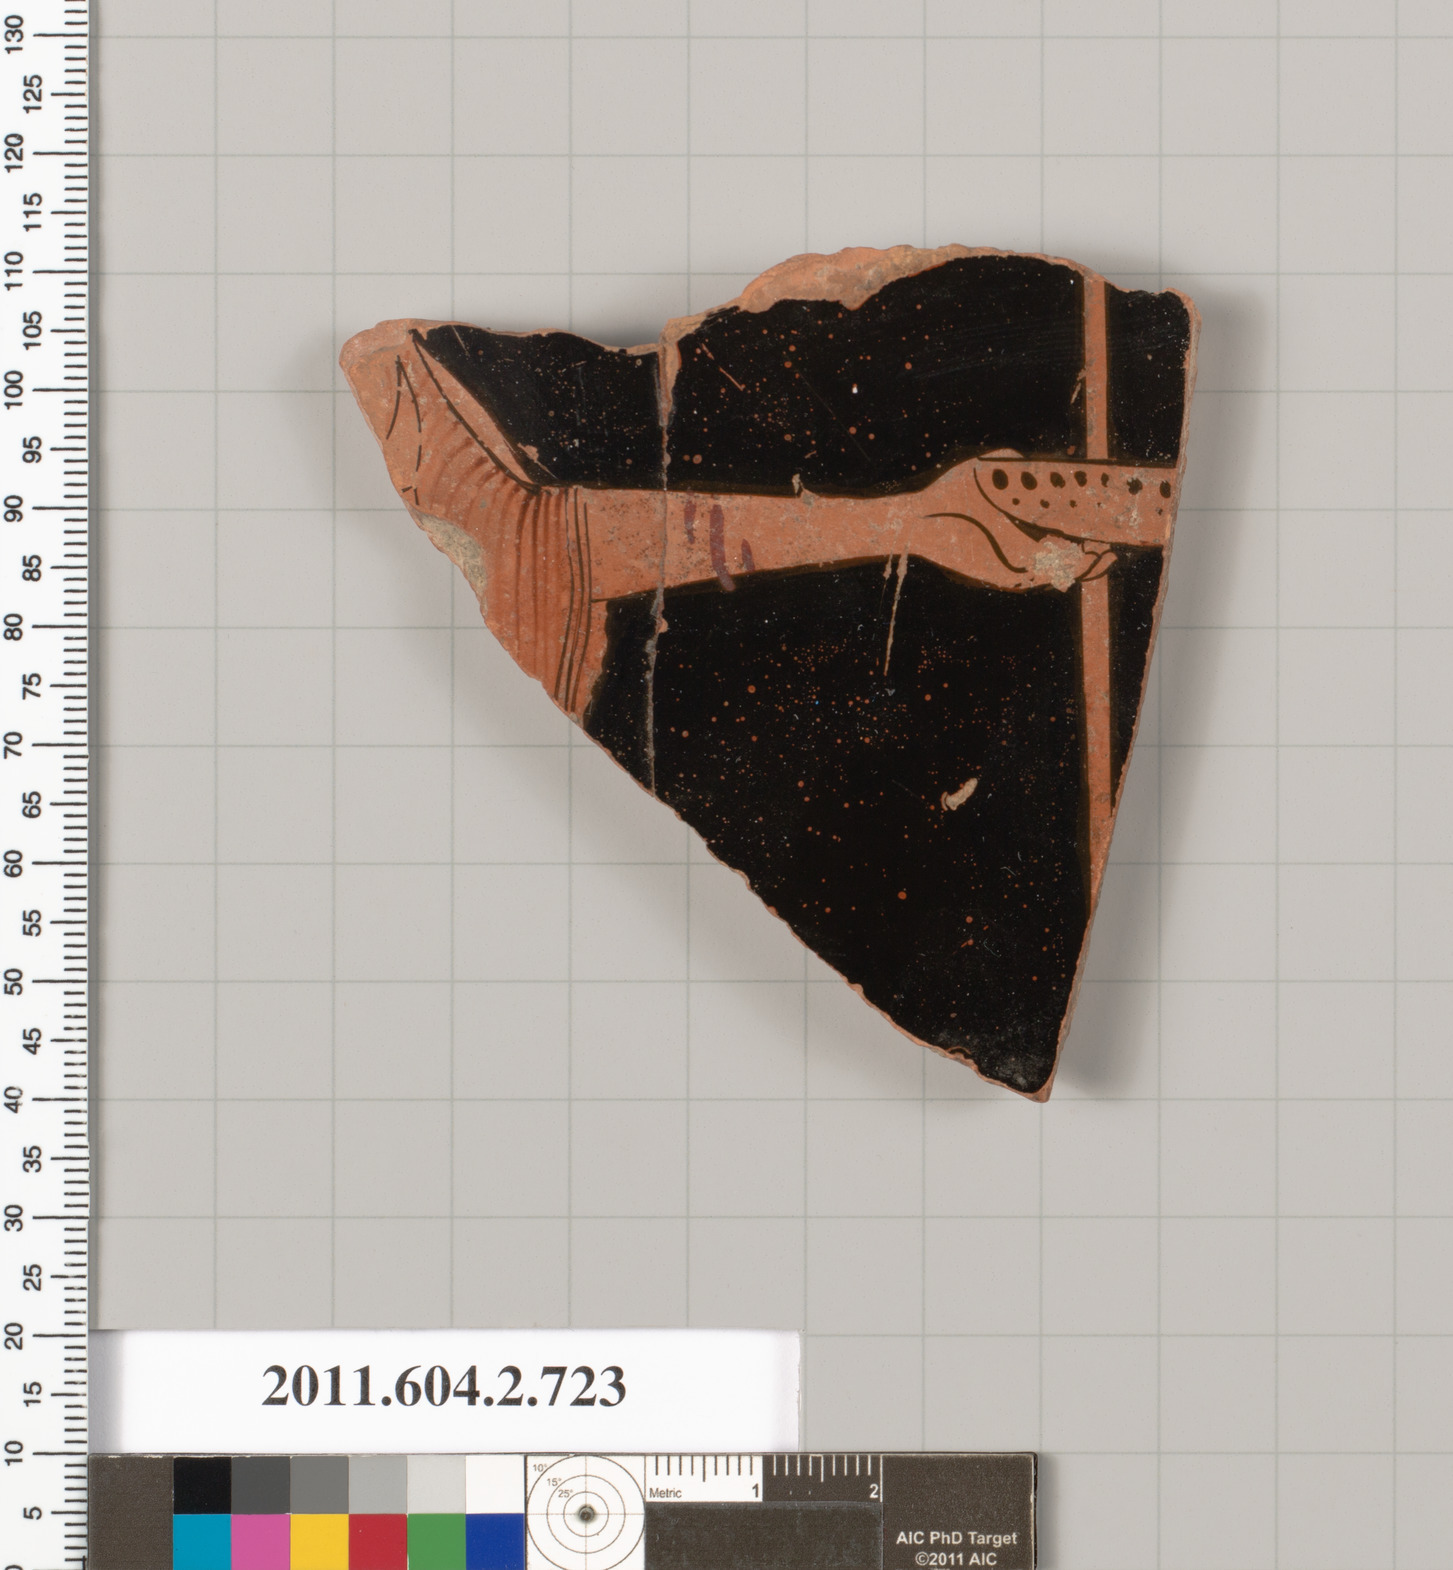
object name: calyx krater fragment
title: Terracotta fragment of a calyx-krater (bowl for mixing wine and water)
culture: greek, attic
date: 470-450 BCE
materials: terracotta